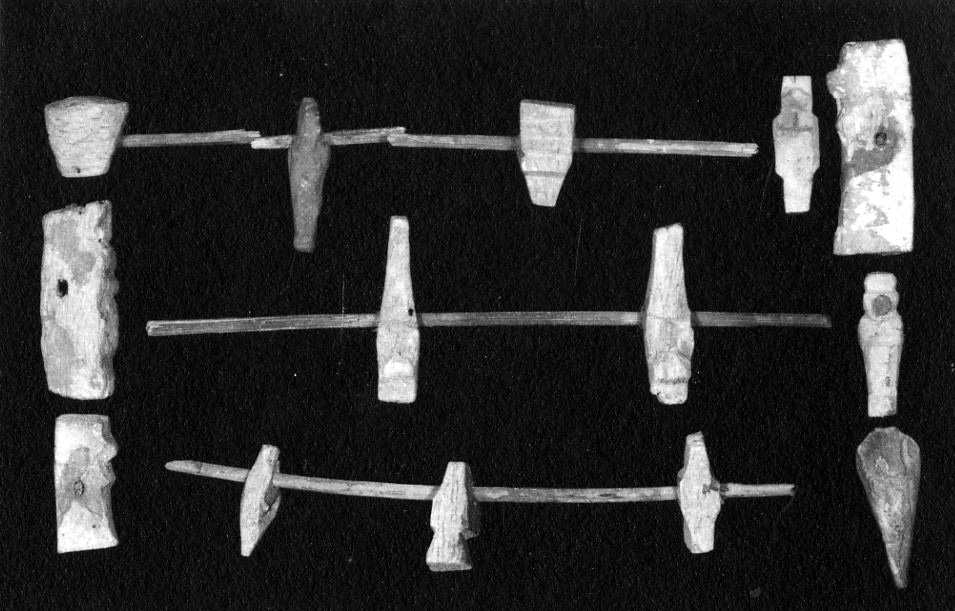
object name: bead, imitation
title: Beads, imitation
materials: paint, wood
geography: egypt